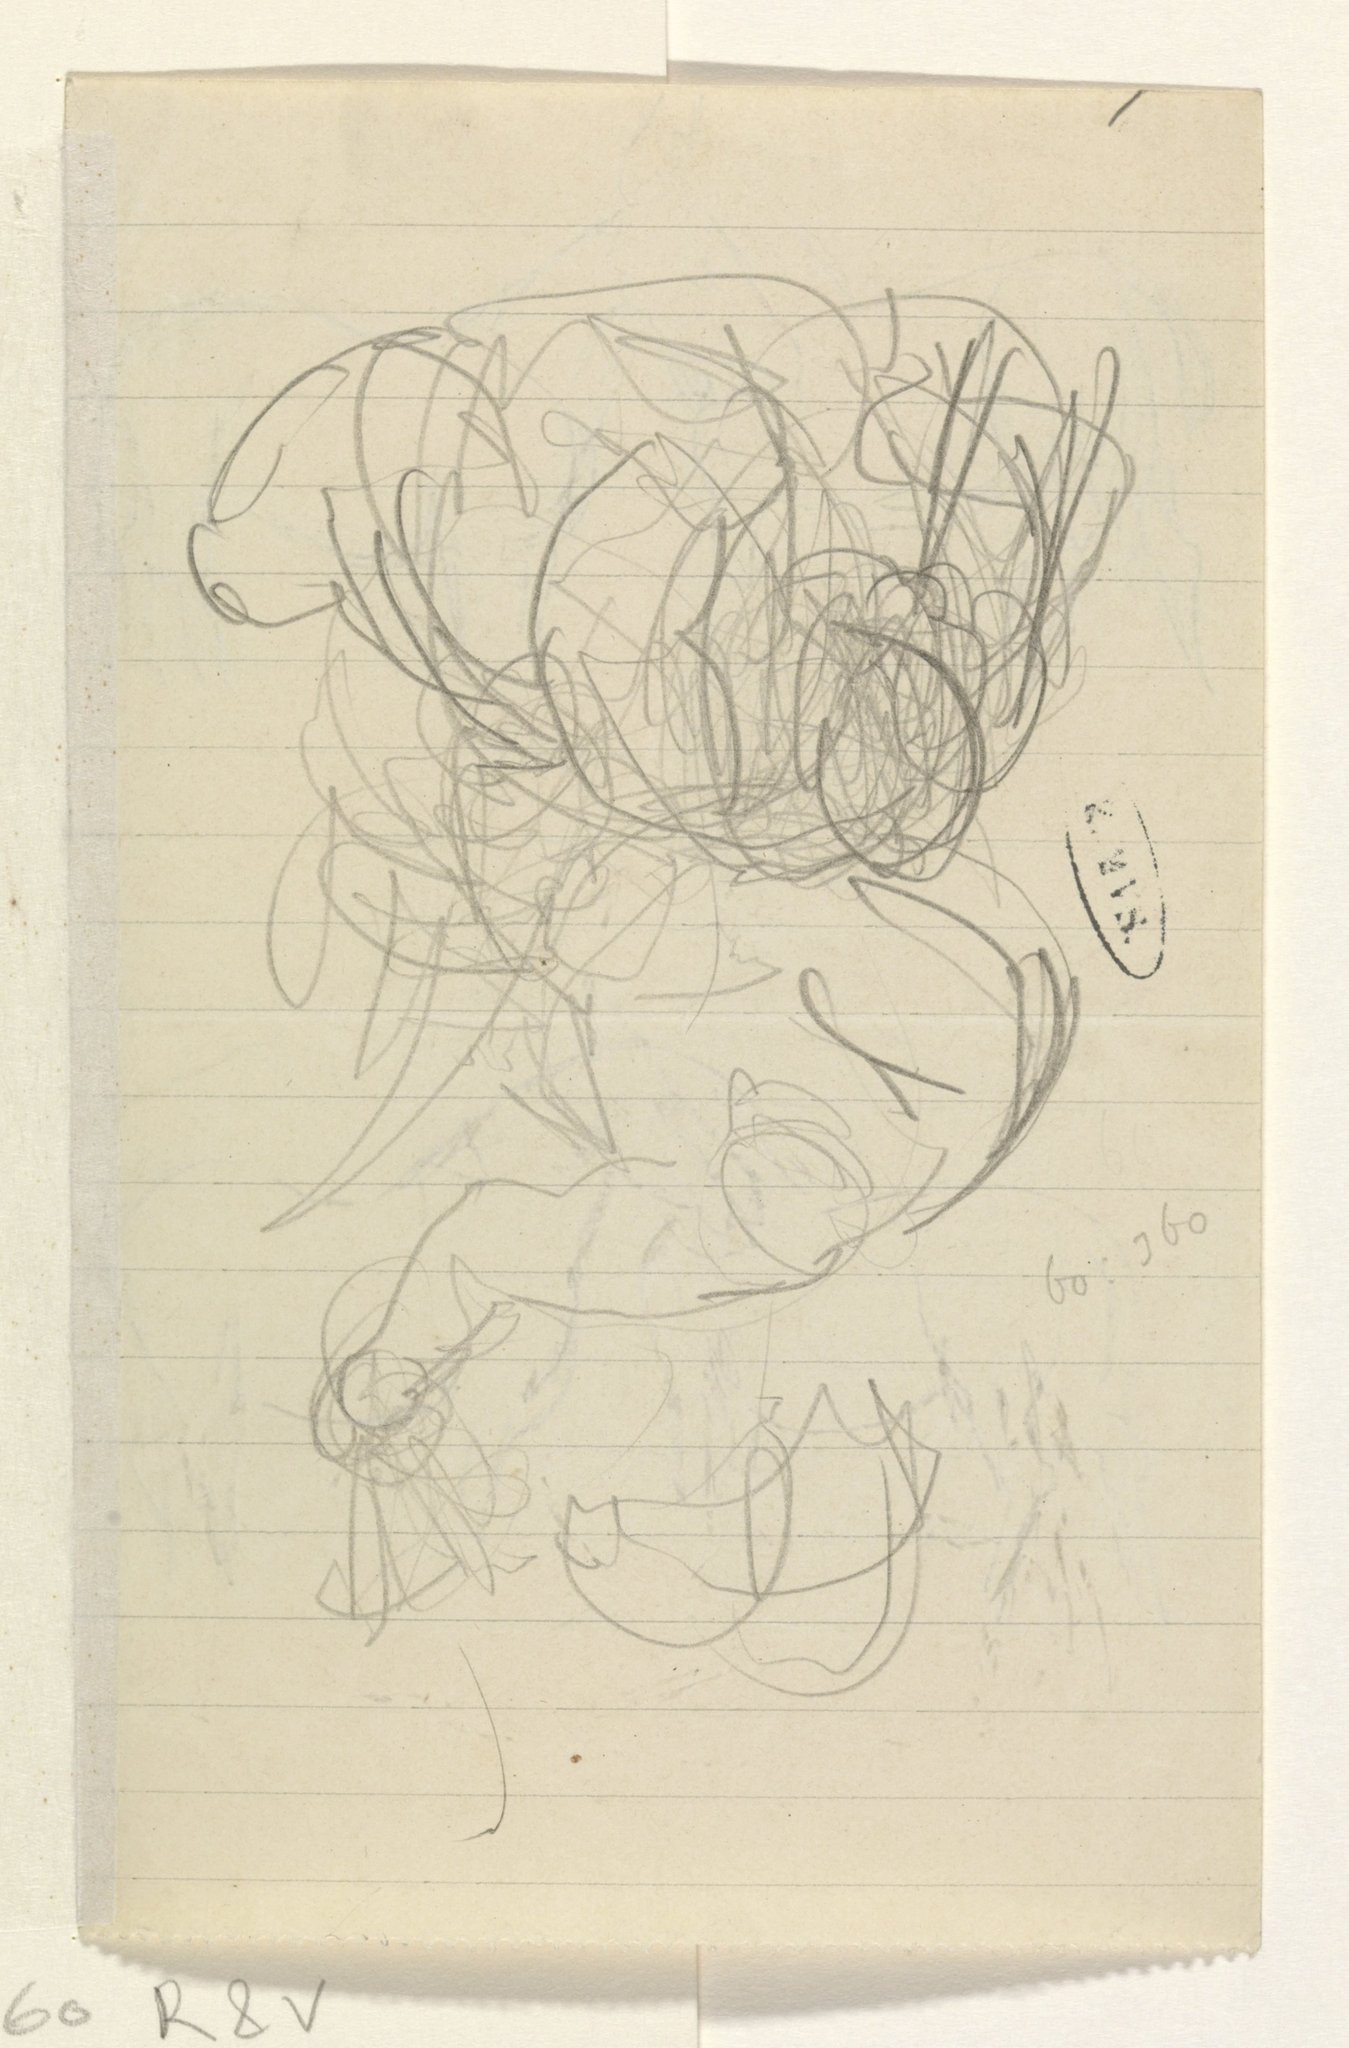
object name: drawing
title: Figuur slaat ander figuur neer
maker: leo gestel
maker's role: draughtsman, print maker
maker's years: 1881-1941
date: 1891-1941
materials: paper, pencil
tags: fighting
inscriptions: collector's mark: Lugt 2228